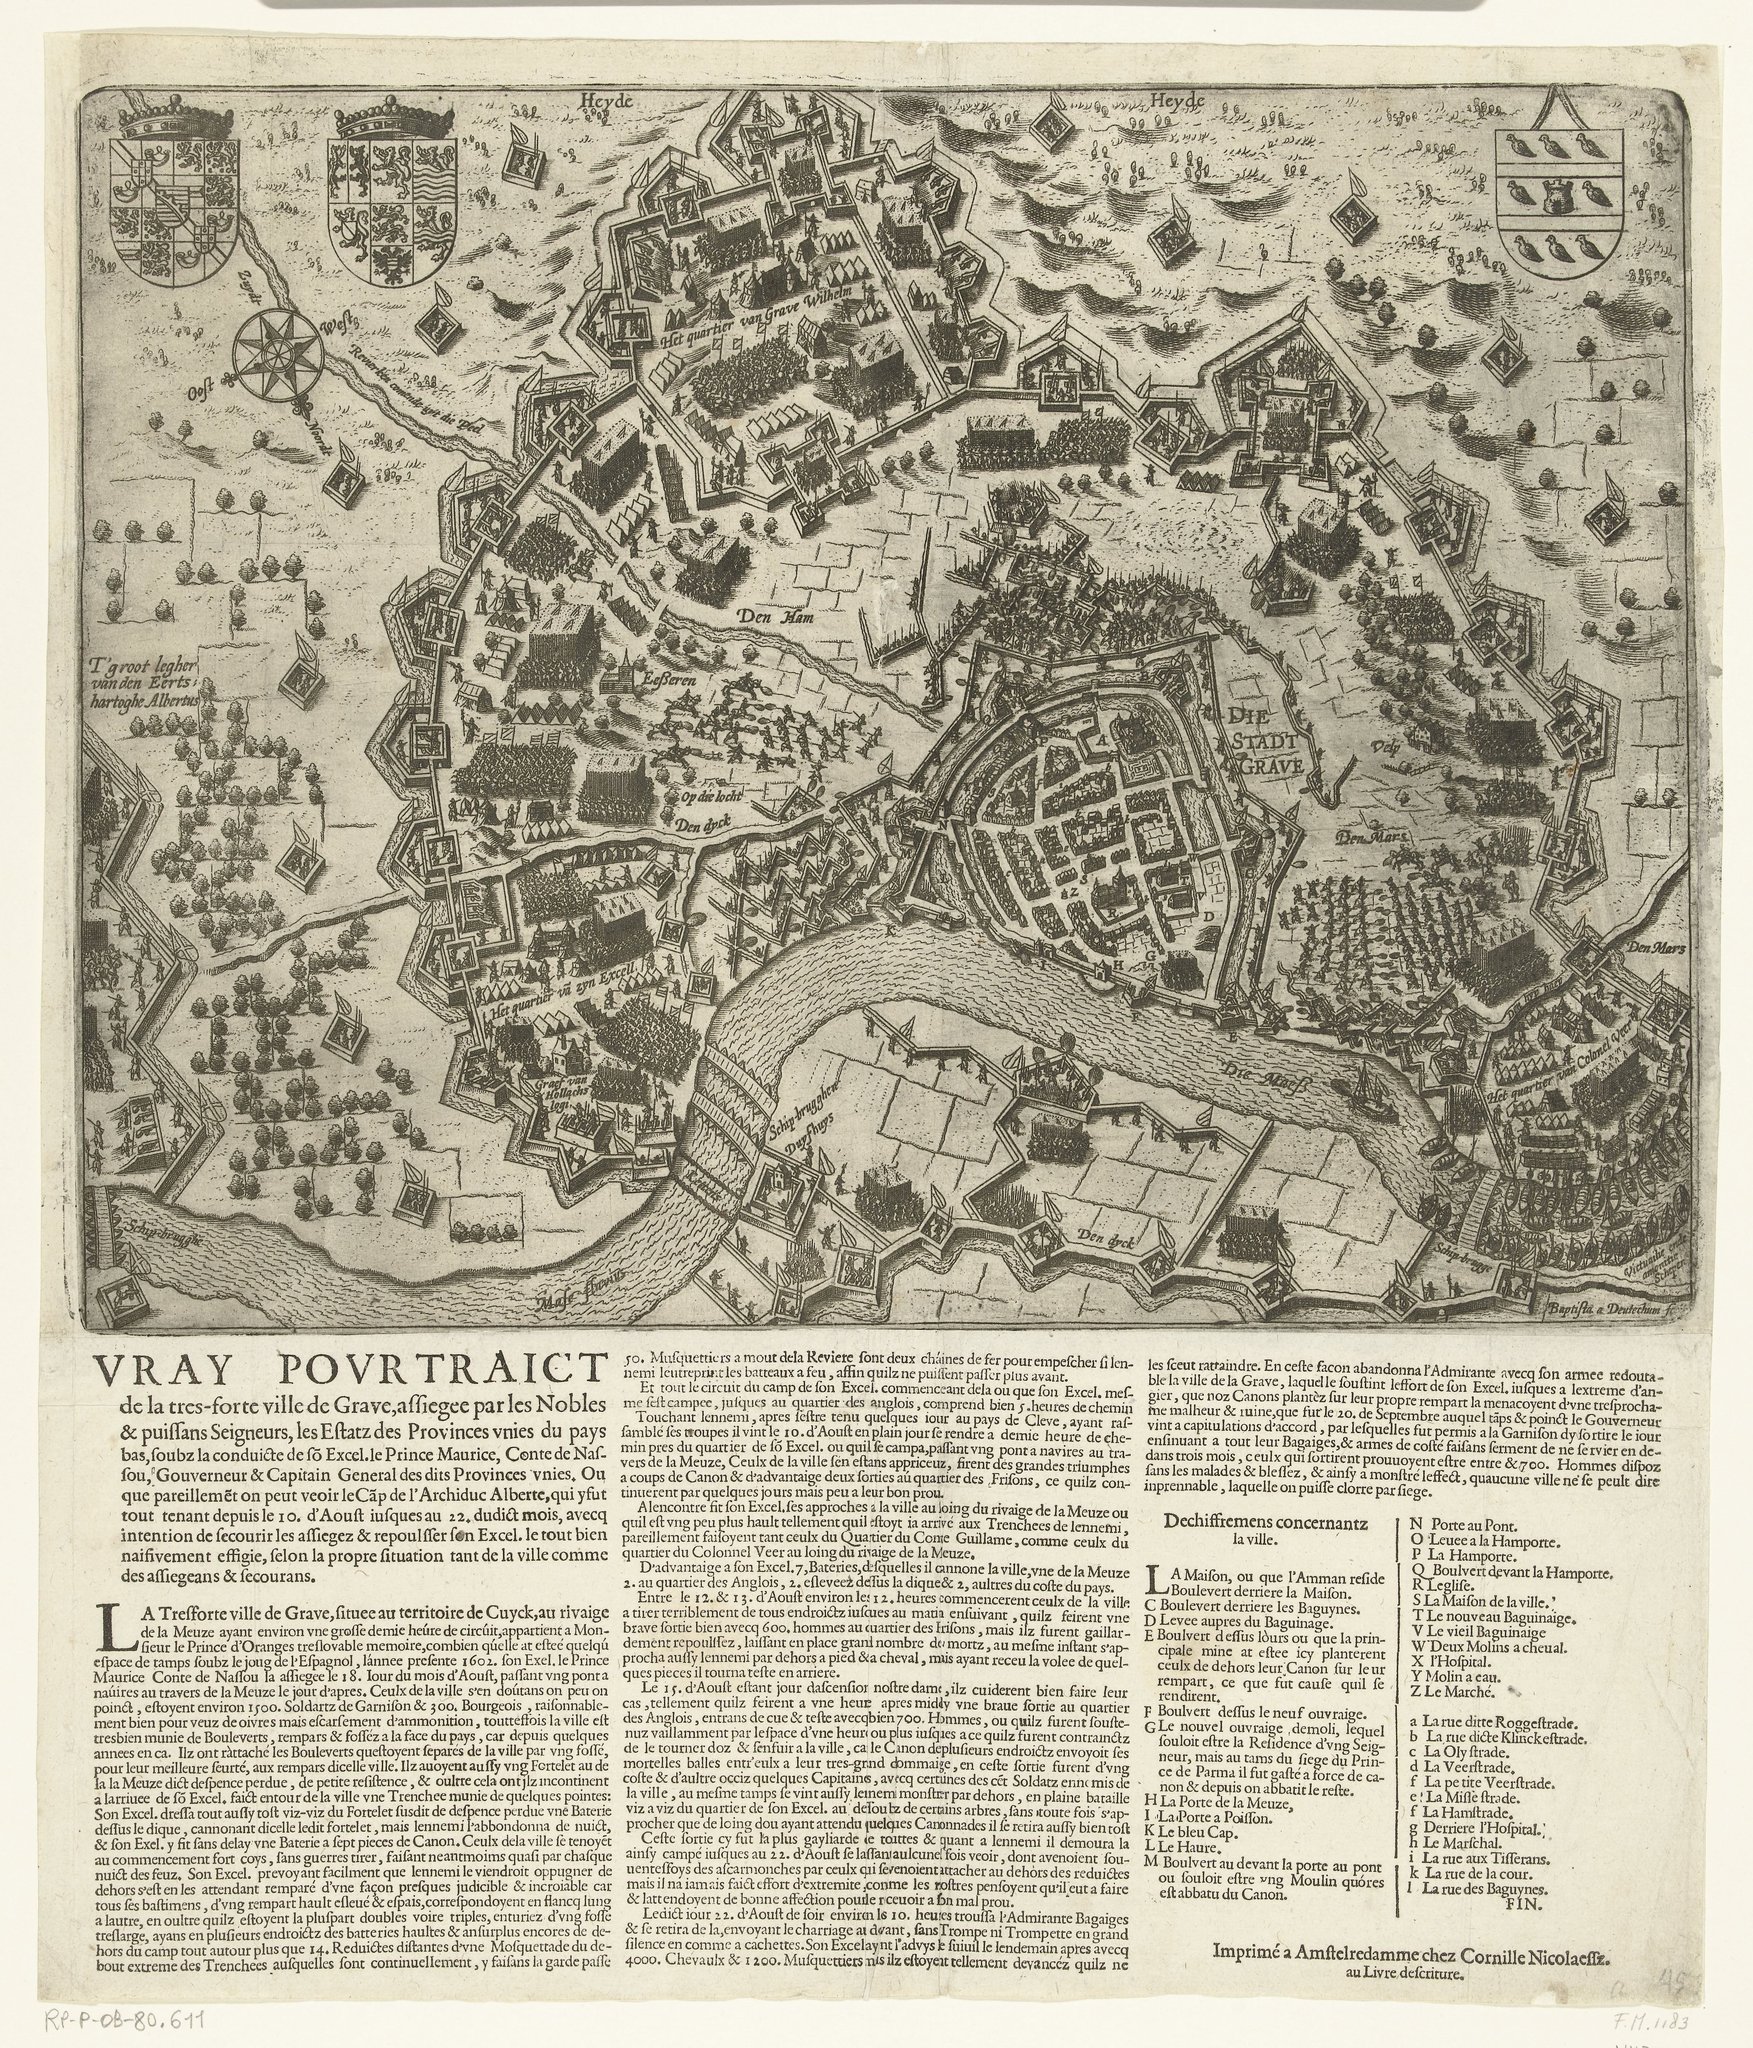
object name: print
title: Beleg en inname van Grave door Maurits, 1602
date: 1602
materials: paper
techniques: etching, letterpress printing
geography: northern netherlands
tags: maurice (prince of orange), willem lodewijk graaf van nassau-dillenburg, brussels, albrecht aartshertog van oostenrijk, maps of separate countries or regions, siege, position war, capture of city (after the siege), grave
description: Beleg en inname van de stad Grave door het Staatse leger onder prins Maurits, 18 juli - 20 september 1602. Kaart van Grave met de verdedigingswerken van de stad en in de omgeving. Met de legerkampen van Maurits, Willem Lodewijk en Francis Vere. Uiterst links het legerkamp van aartshertog Albrecht. Linksboven de wapens van de Staten-Generaal en van Maurits, rechtsboven het stadswapen van Grave. Apart gedrukt onder de voorstelling een Franse tekst in 3 kolommen, met de legenda A-Z en a-l.